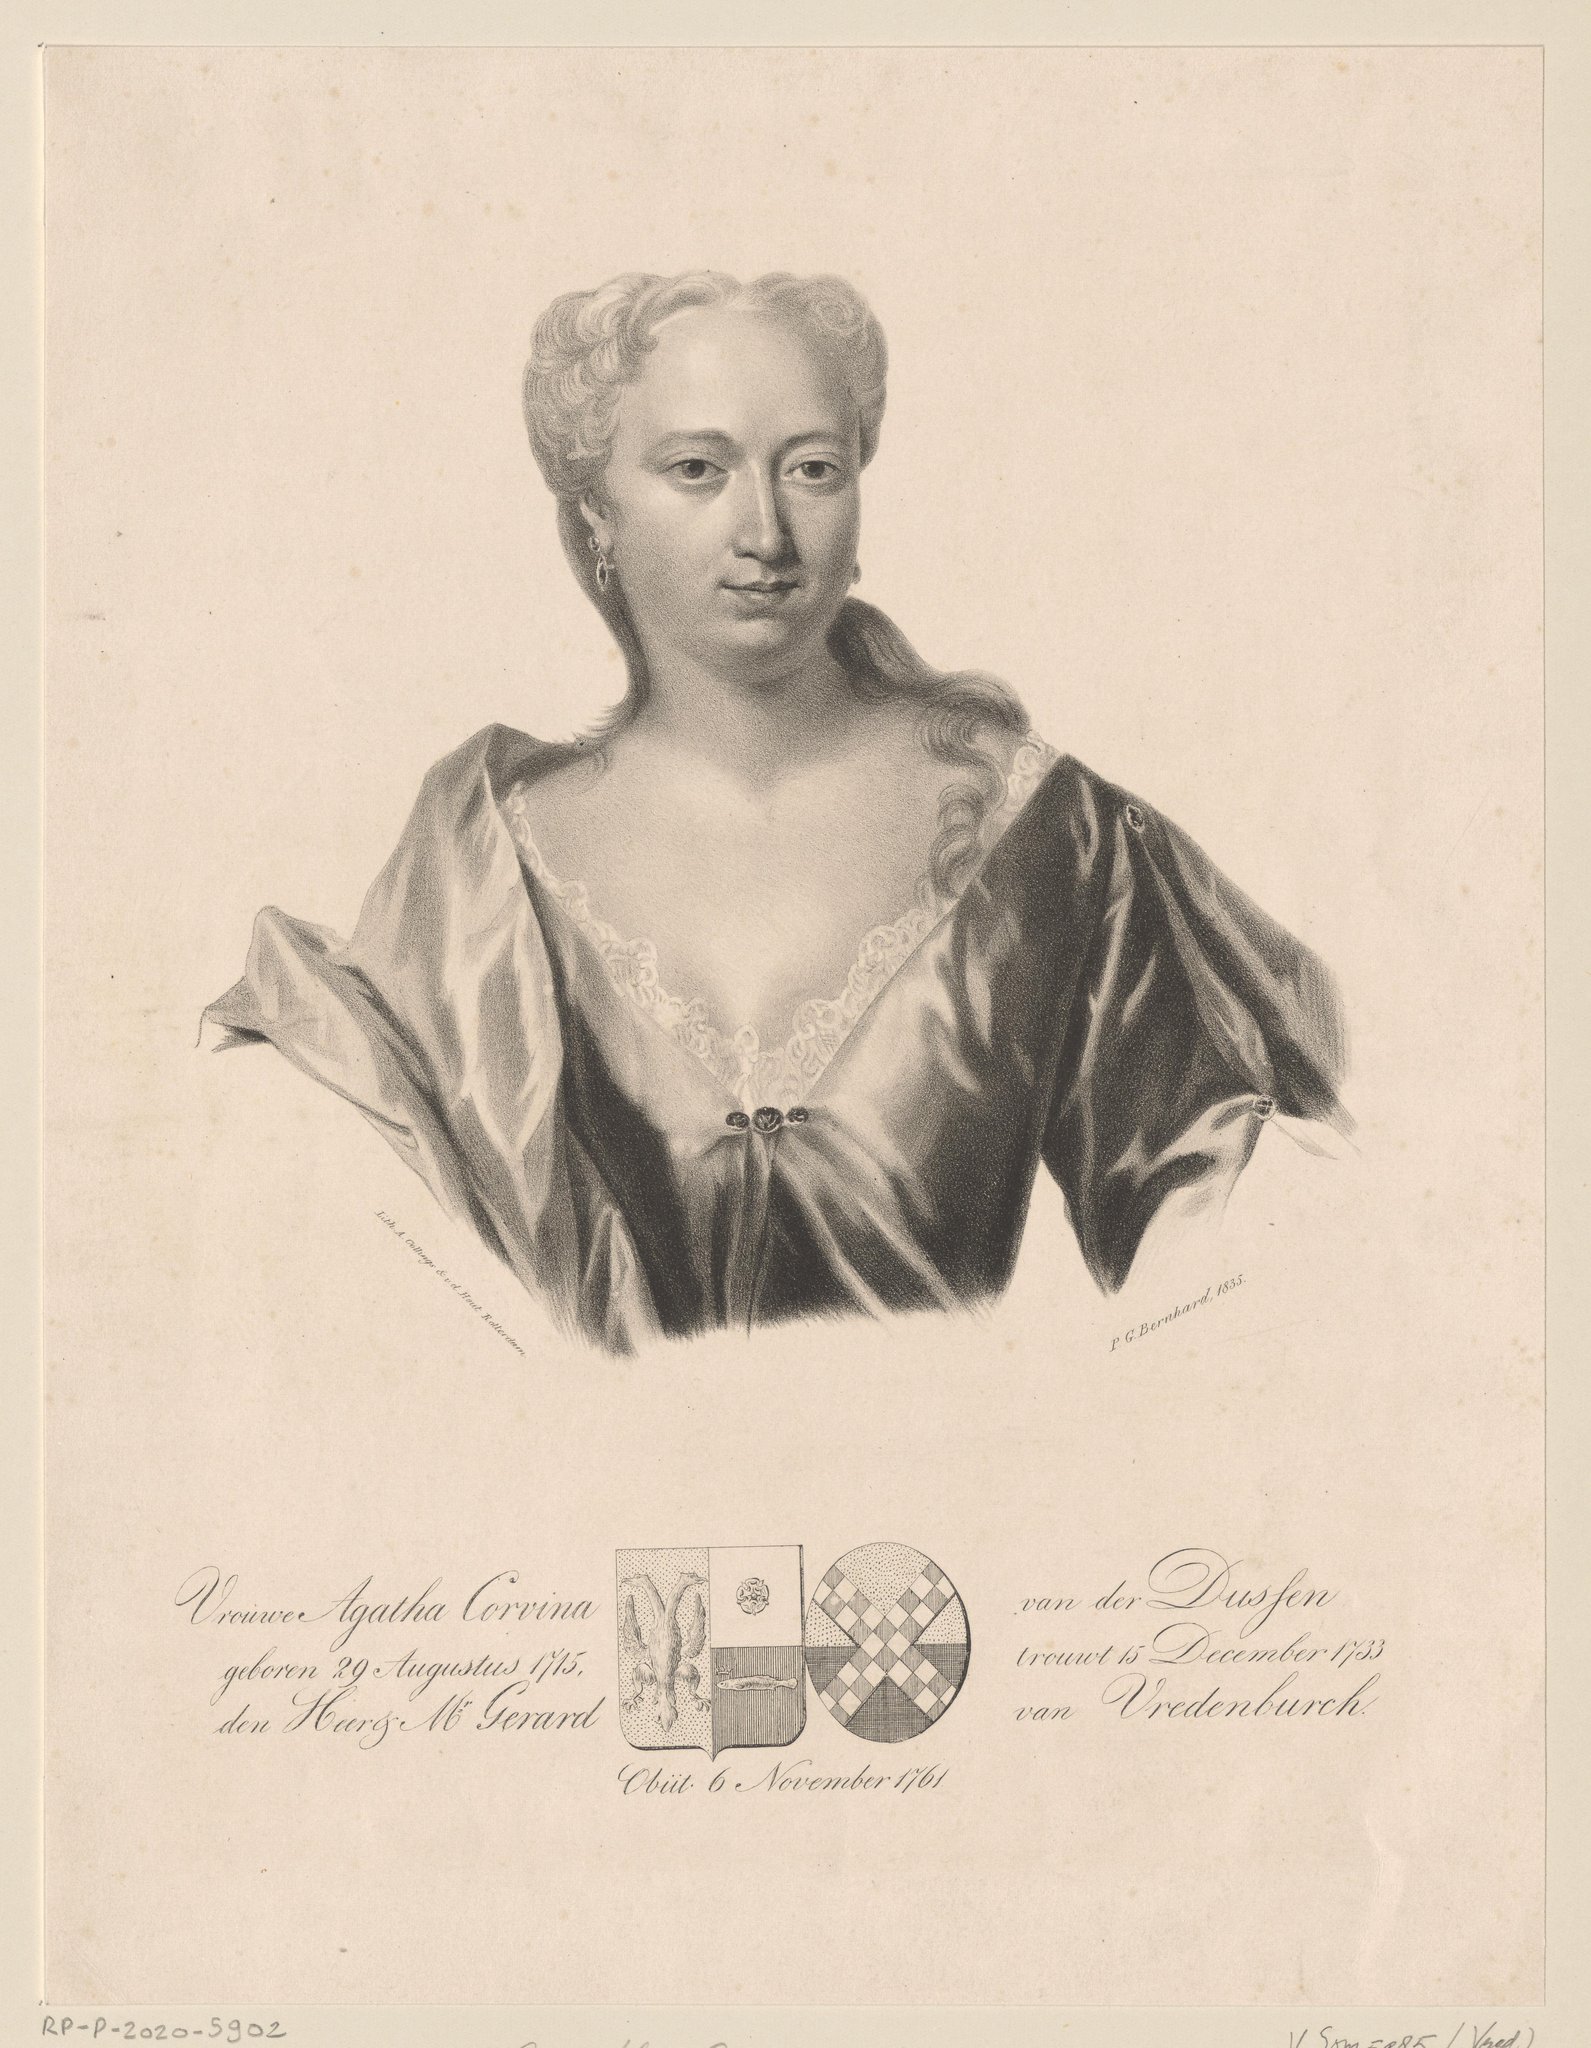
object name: print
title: Portret van Agatha Corvina van der Dussen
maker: pieter gerardus bernhard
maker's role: print maker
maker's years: 1813-1880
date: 1835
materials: paper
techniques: lithograph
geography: rotterdam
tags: historical persons - bb - woman